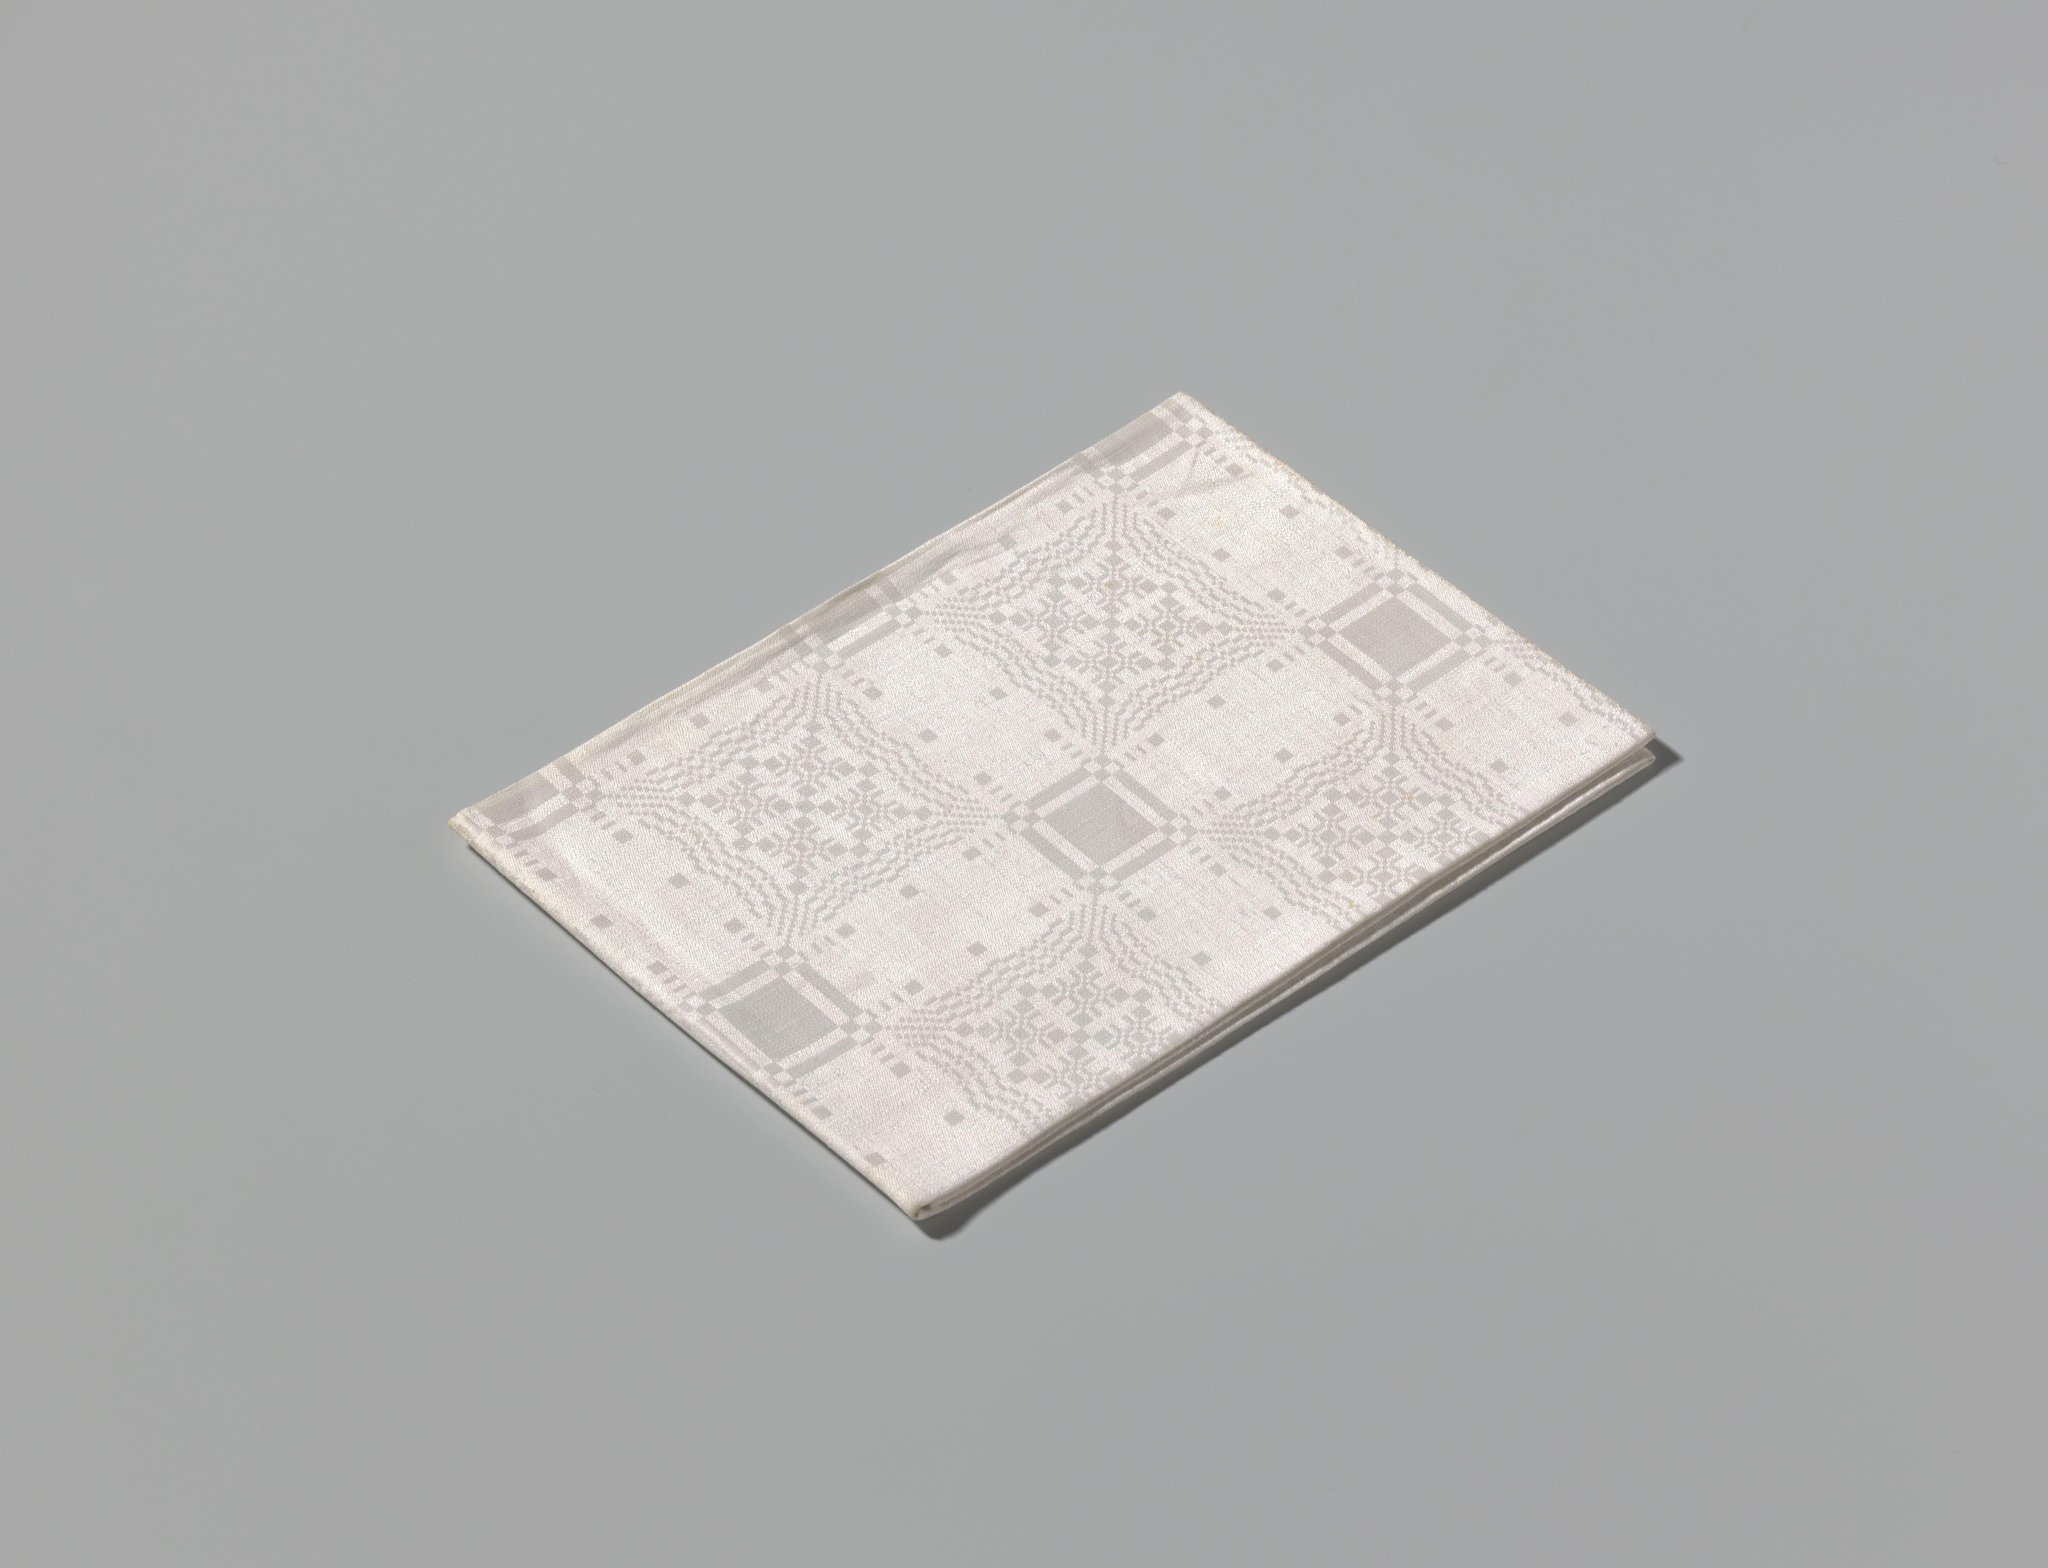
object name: napkin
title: Servet van linnen met pellenpatroon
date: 1734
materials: linen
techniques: peeled fabric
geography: northern netherlands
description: wit linnen servet met pellen patroon, merk AVG 38 en 1734